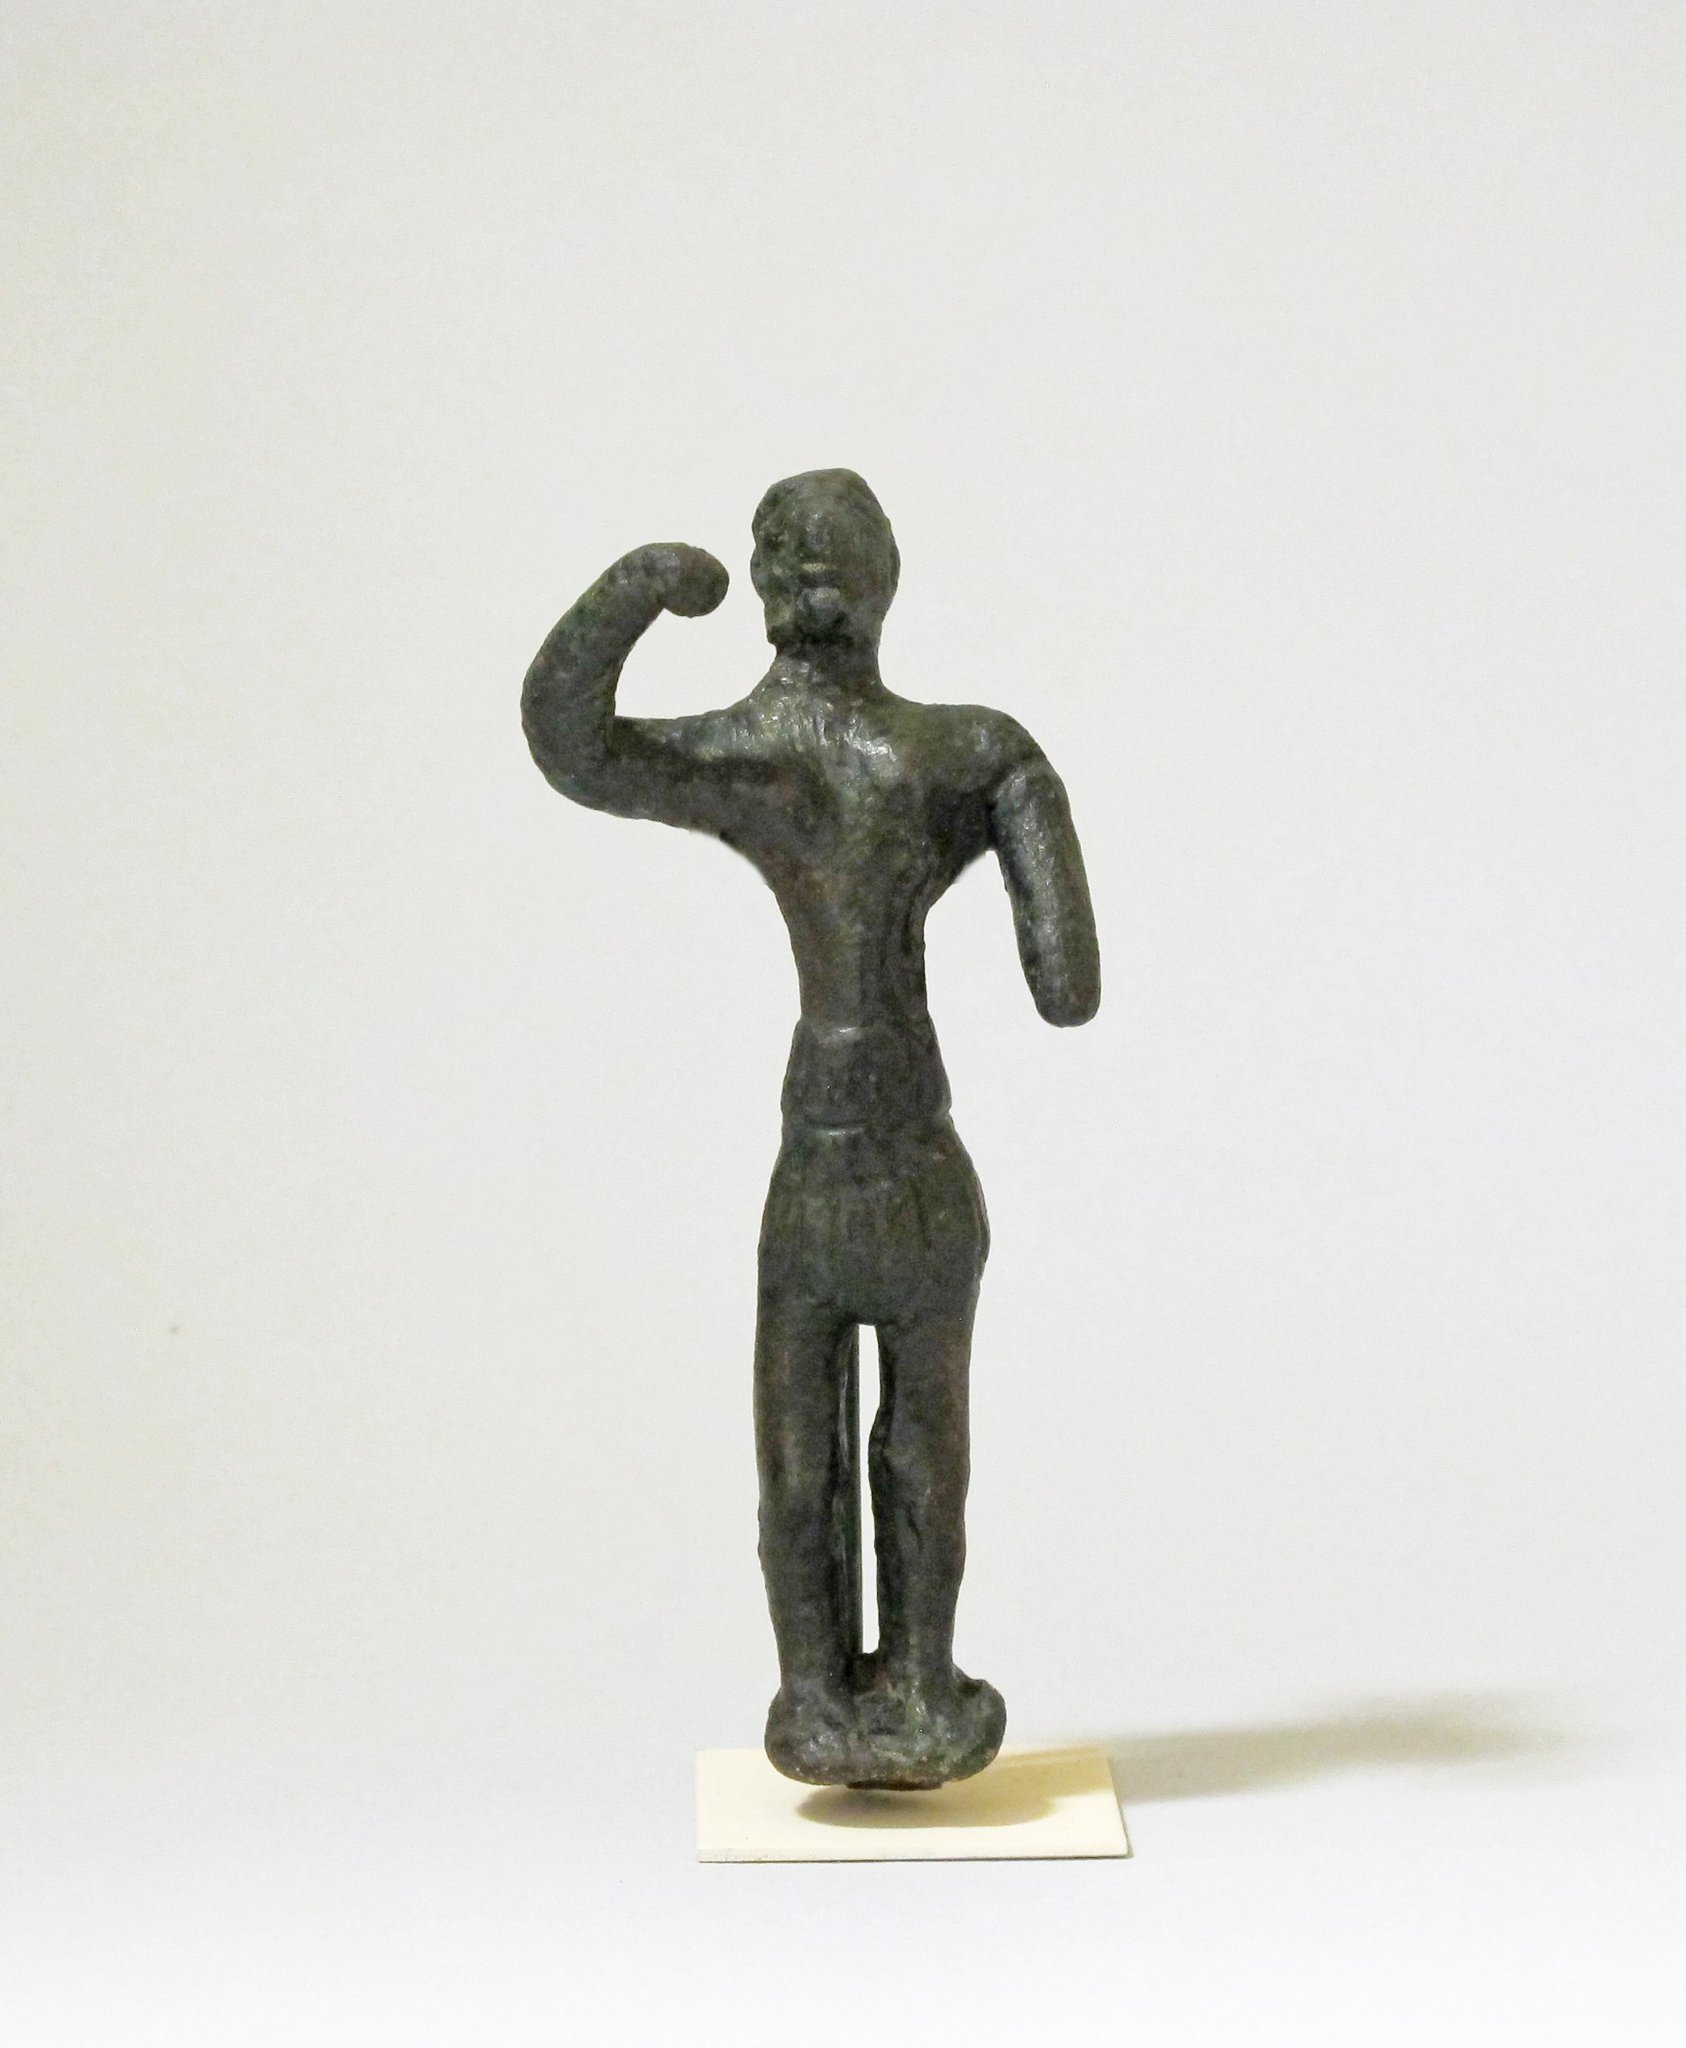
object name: statuette of a votary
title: Bronze statuette of a male votary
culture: minoan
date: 1400-1050 BCE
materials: bronze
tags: men